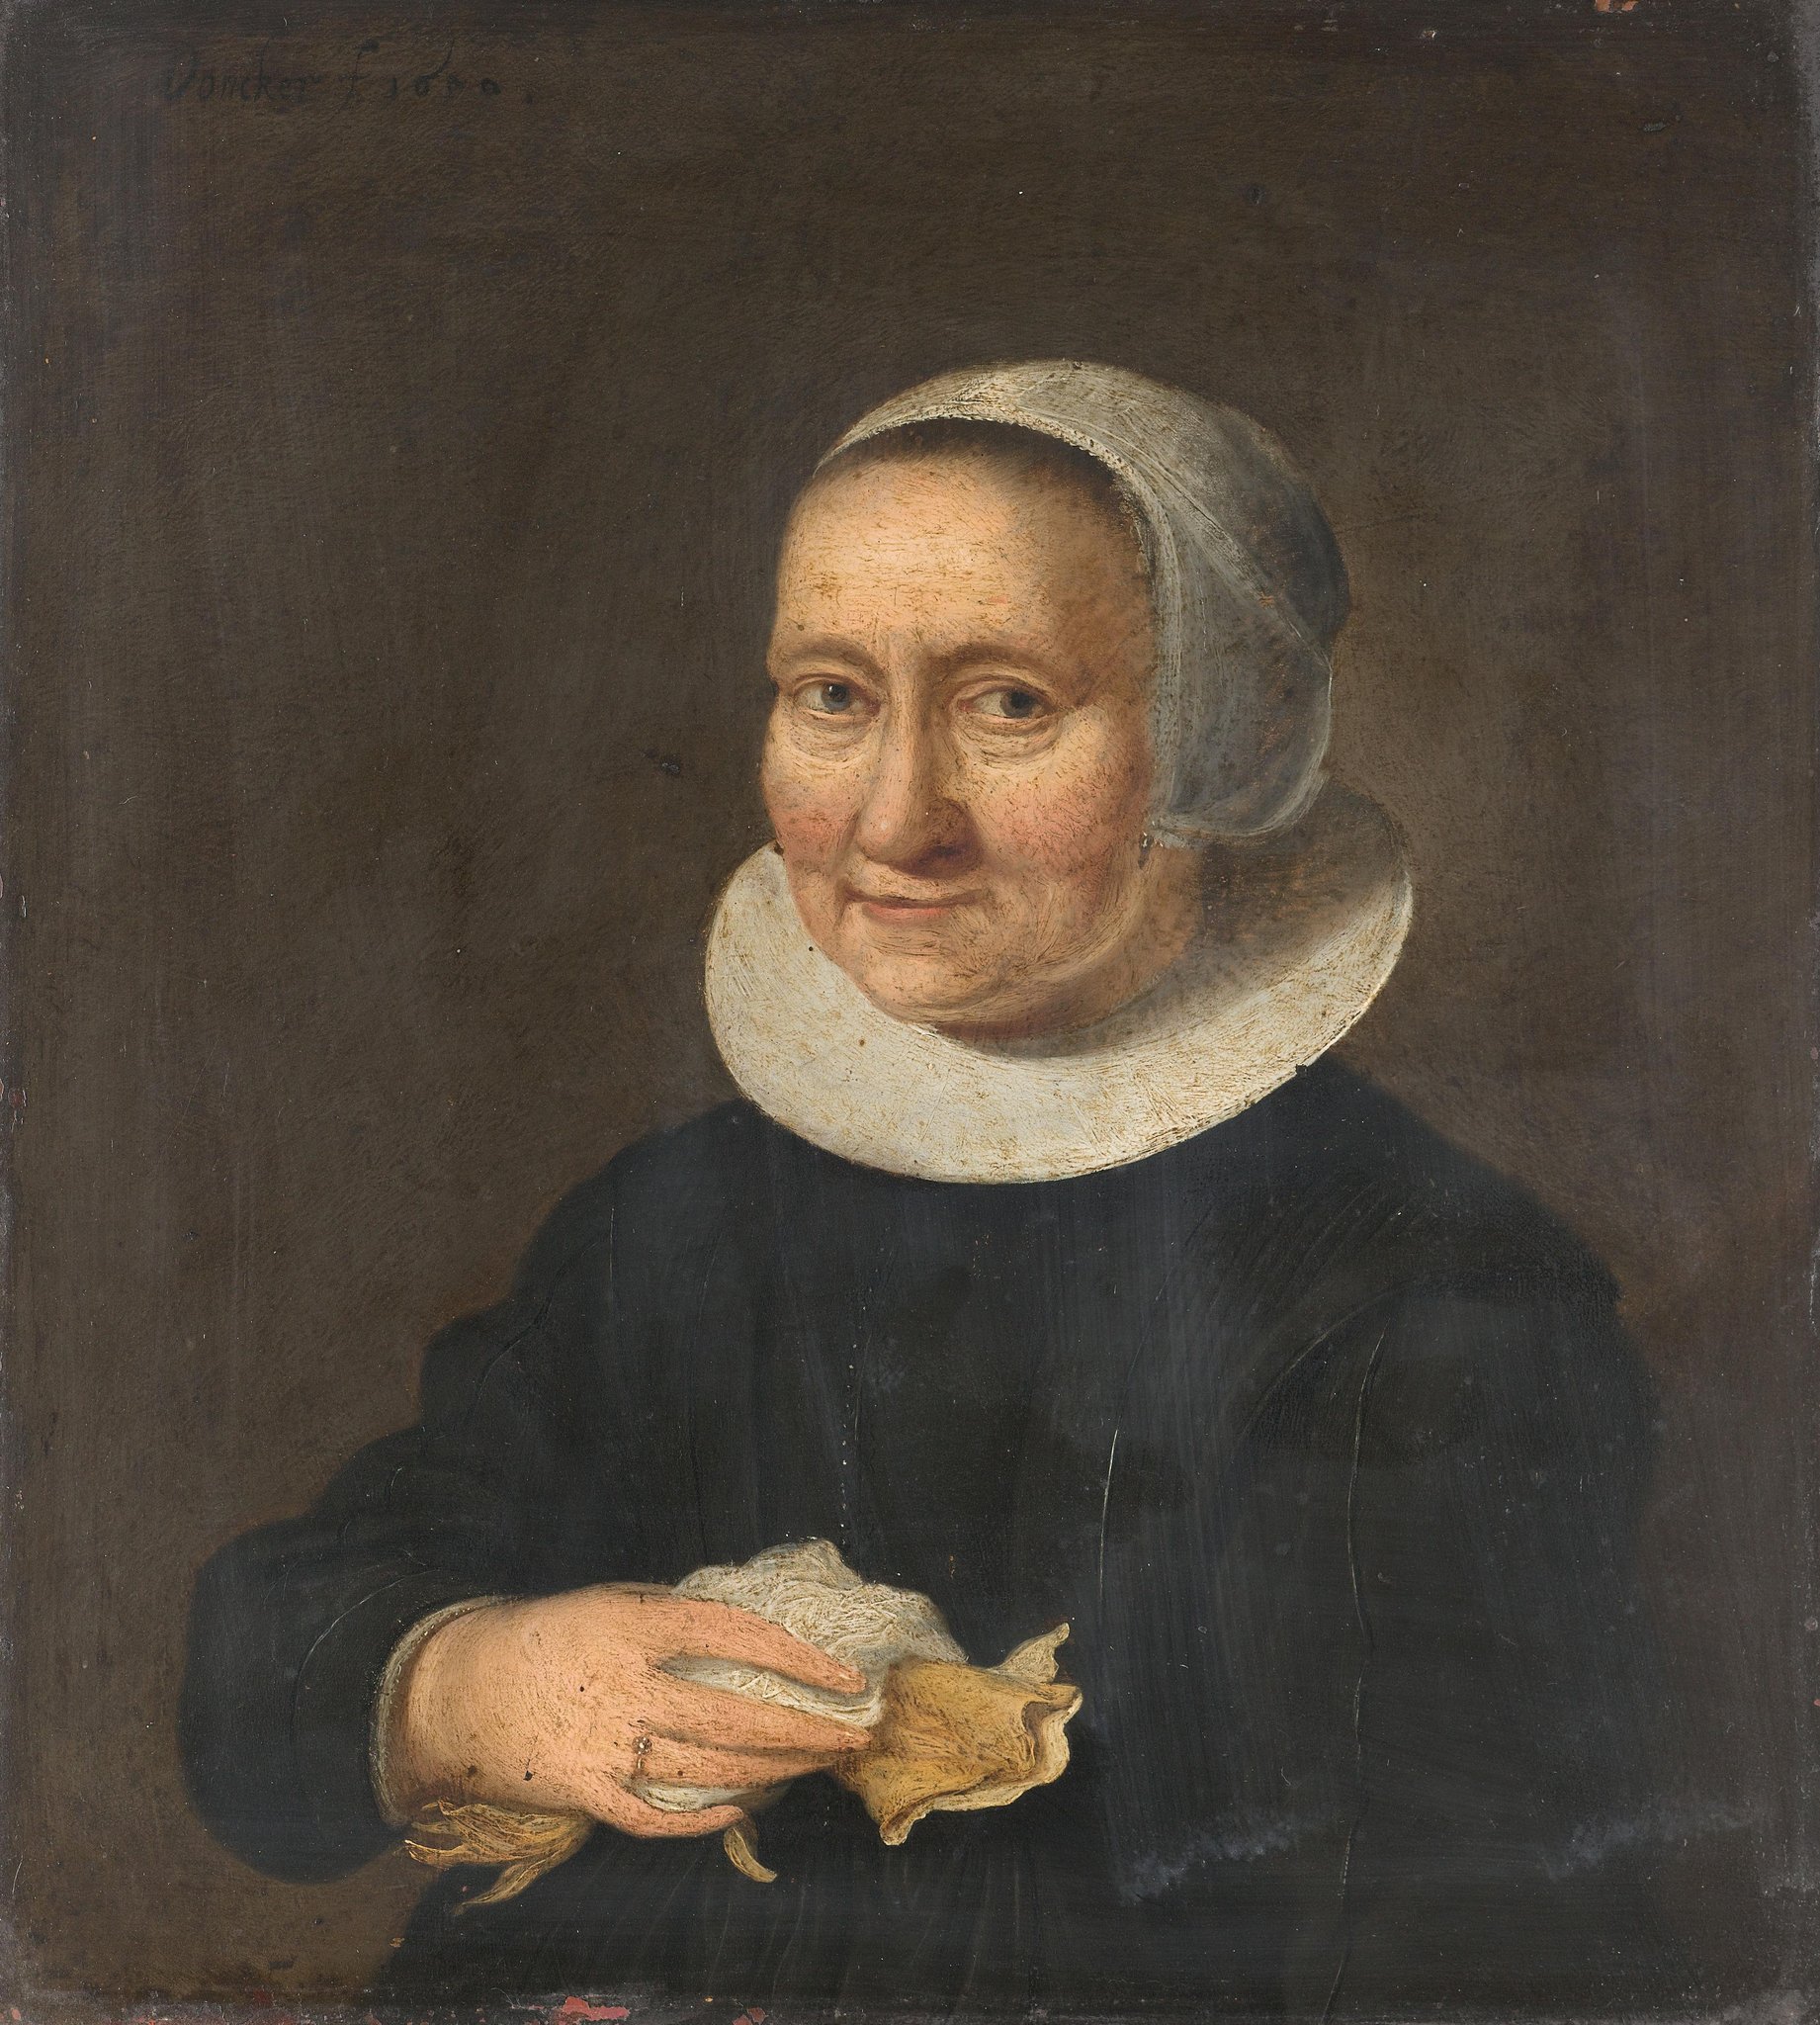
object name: painting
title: Portrait of a Woman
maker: herman meynderts doncker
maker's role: painter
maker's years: 1595-1656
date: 1650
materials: copper, oil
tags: historical persons not known by name - bb - woman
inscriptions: signature and date: ‘Doncker f. 1650’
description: Portret van een onbekende vrouw. In de rechterhand een handschoen en een zakdoek. Pendant van SK-A-1689.